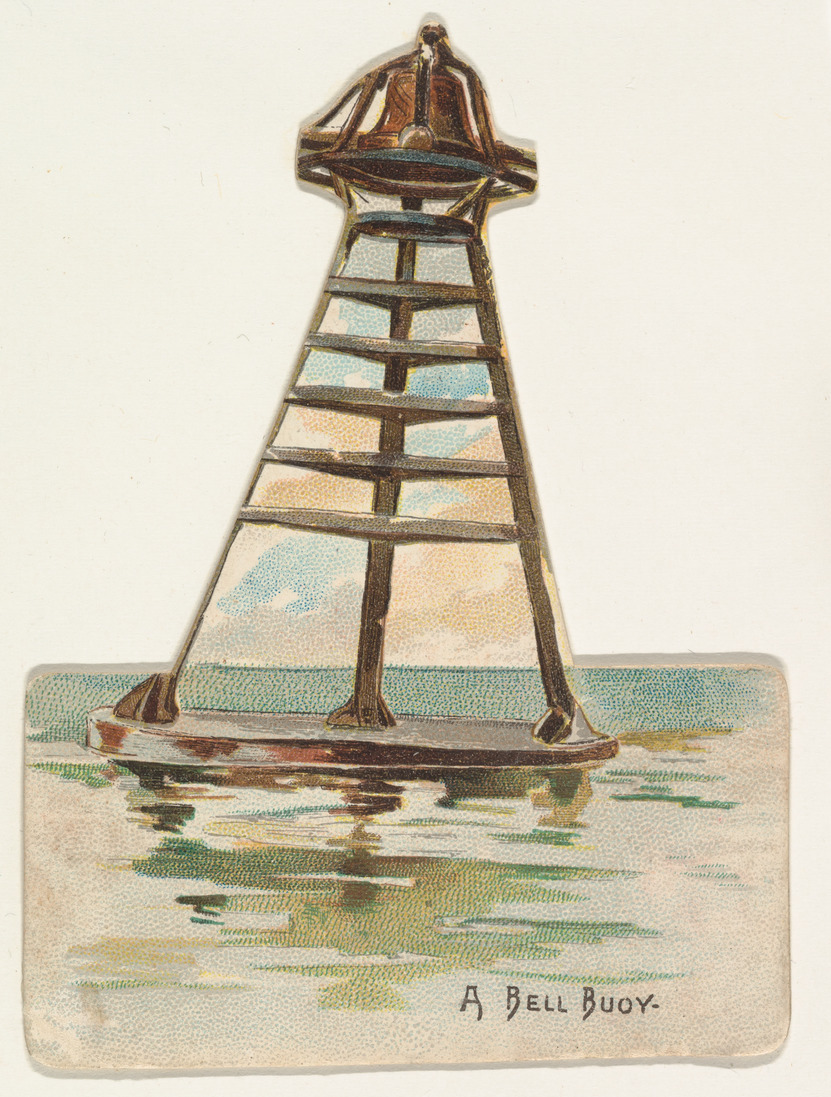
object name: print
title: A Bell Buoy, from the Lighthouses series (N119) issued by Duke Sons & Co. to promote Honest Long Cut Tobacco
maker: w. duke, sons & co.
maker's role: publisher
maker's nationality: american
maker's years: 1870-1920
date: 1889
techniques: color lithograph